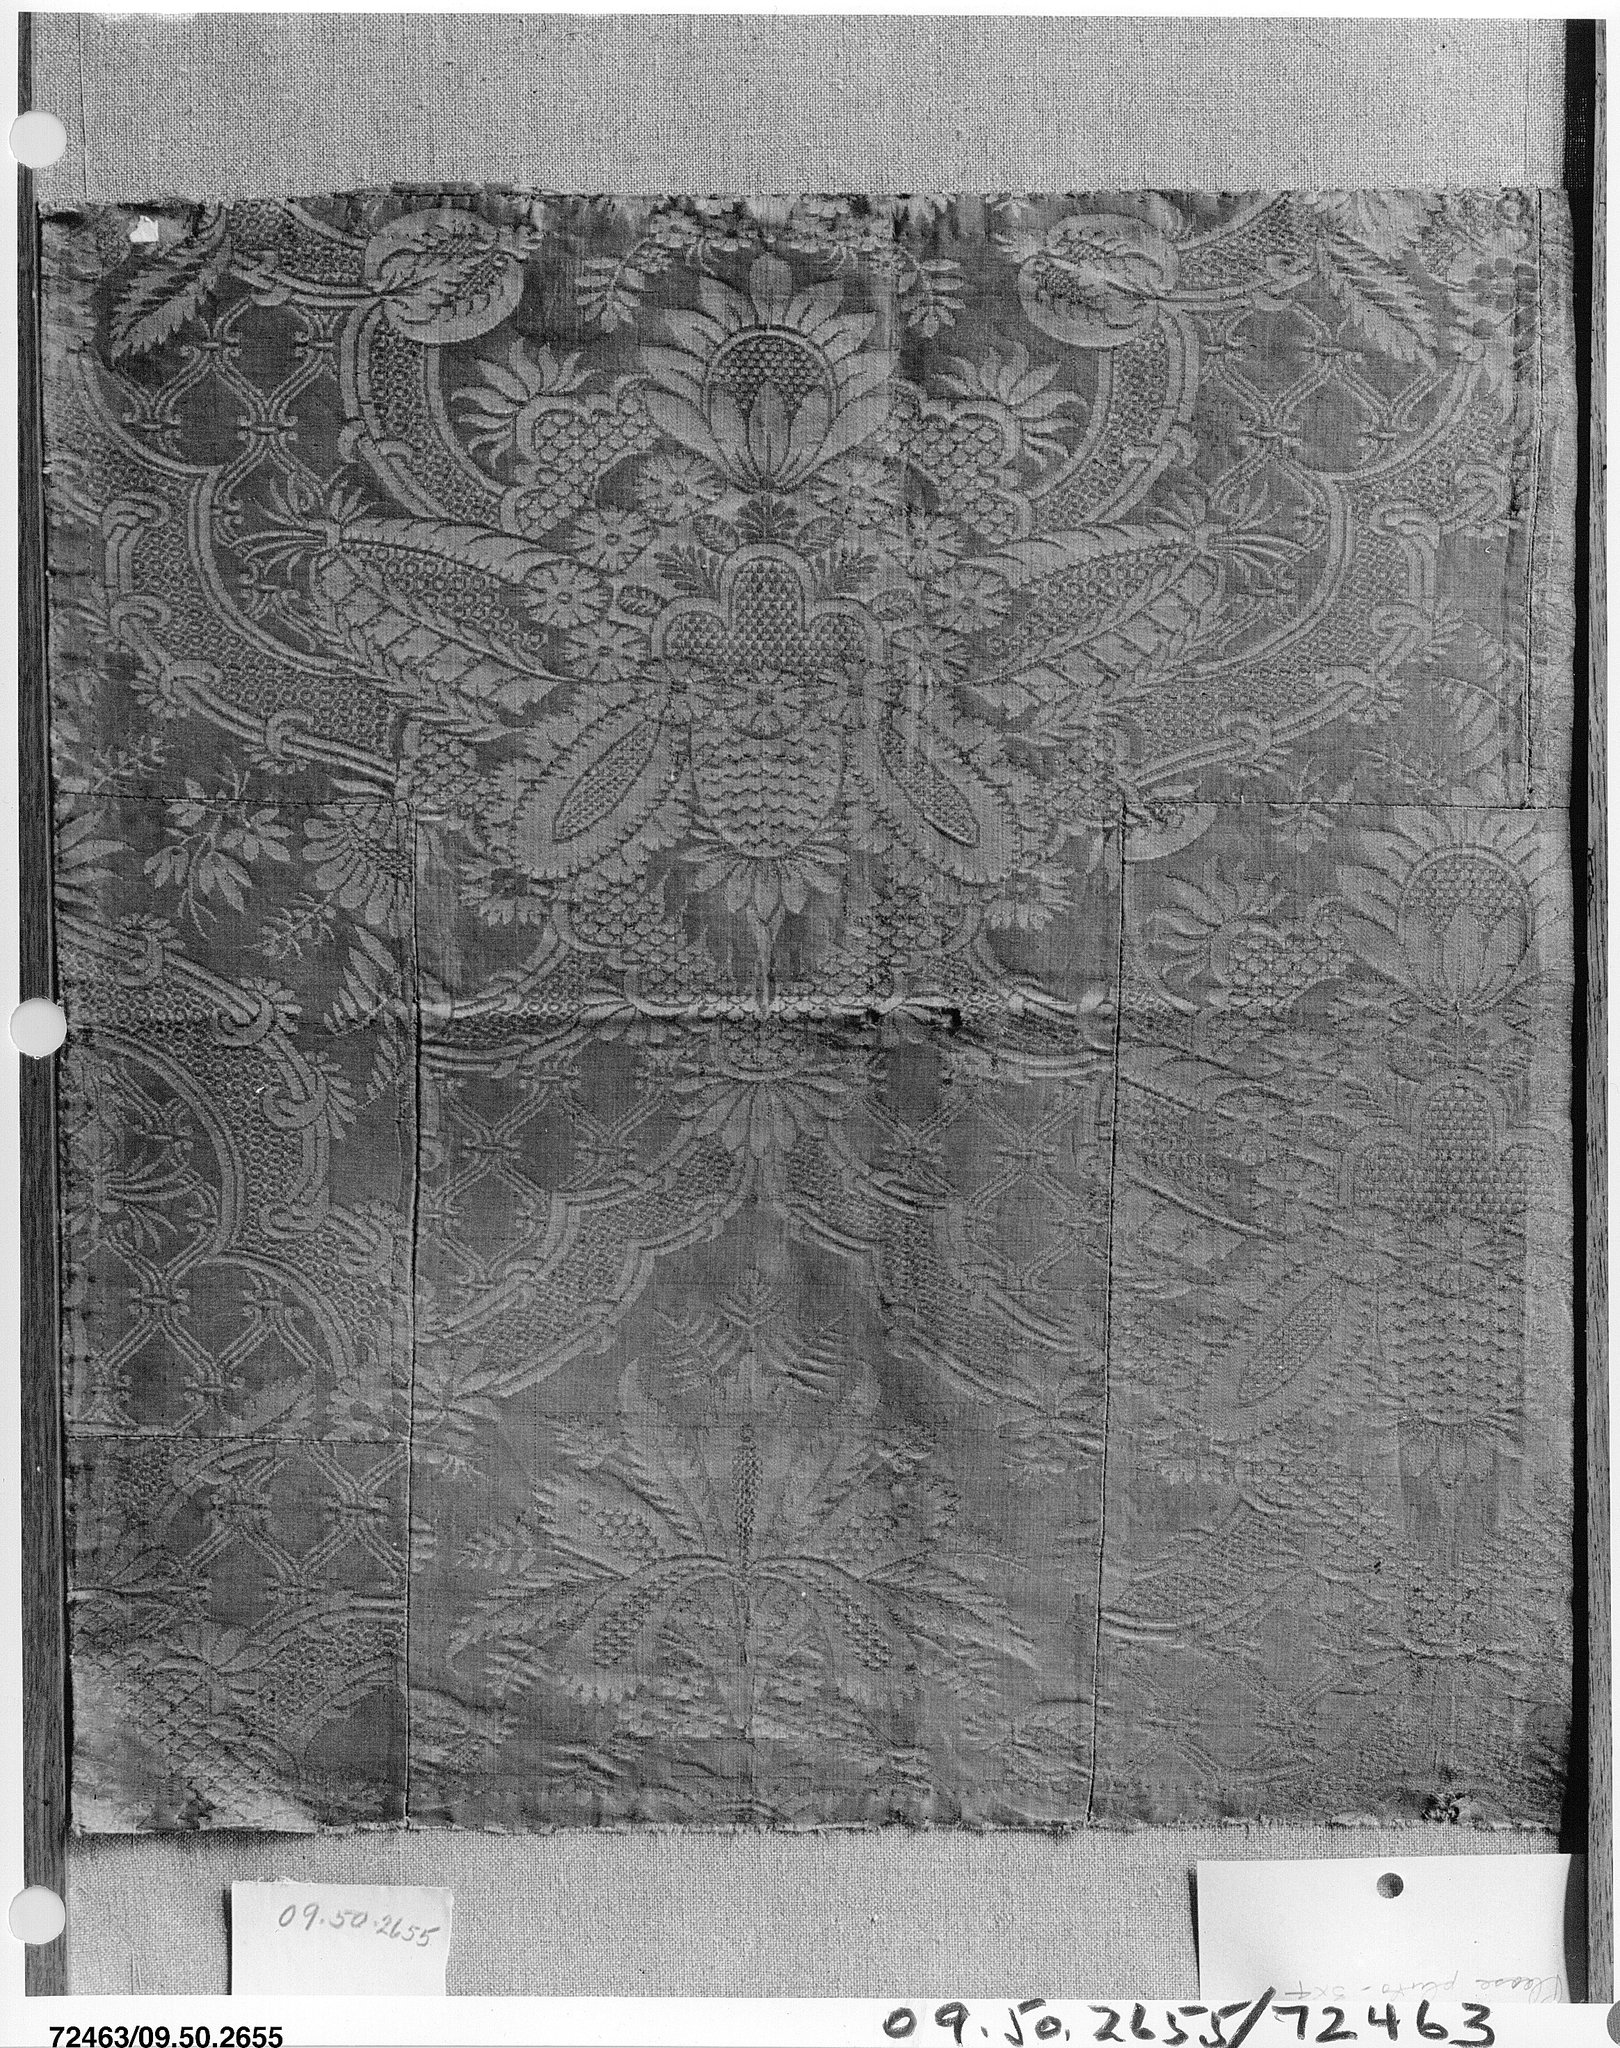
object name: piece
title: Fragment of silk damask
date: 1701-1733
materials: silk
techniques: damask, weave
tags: flowers,leaves